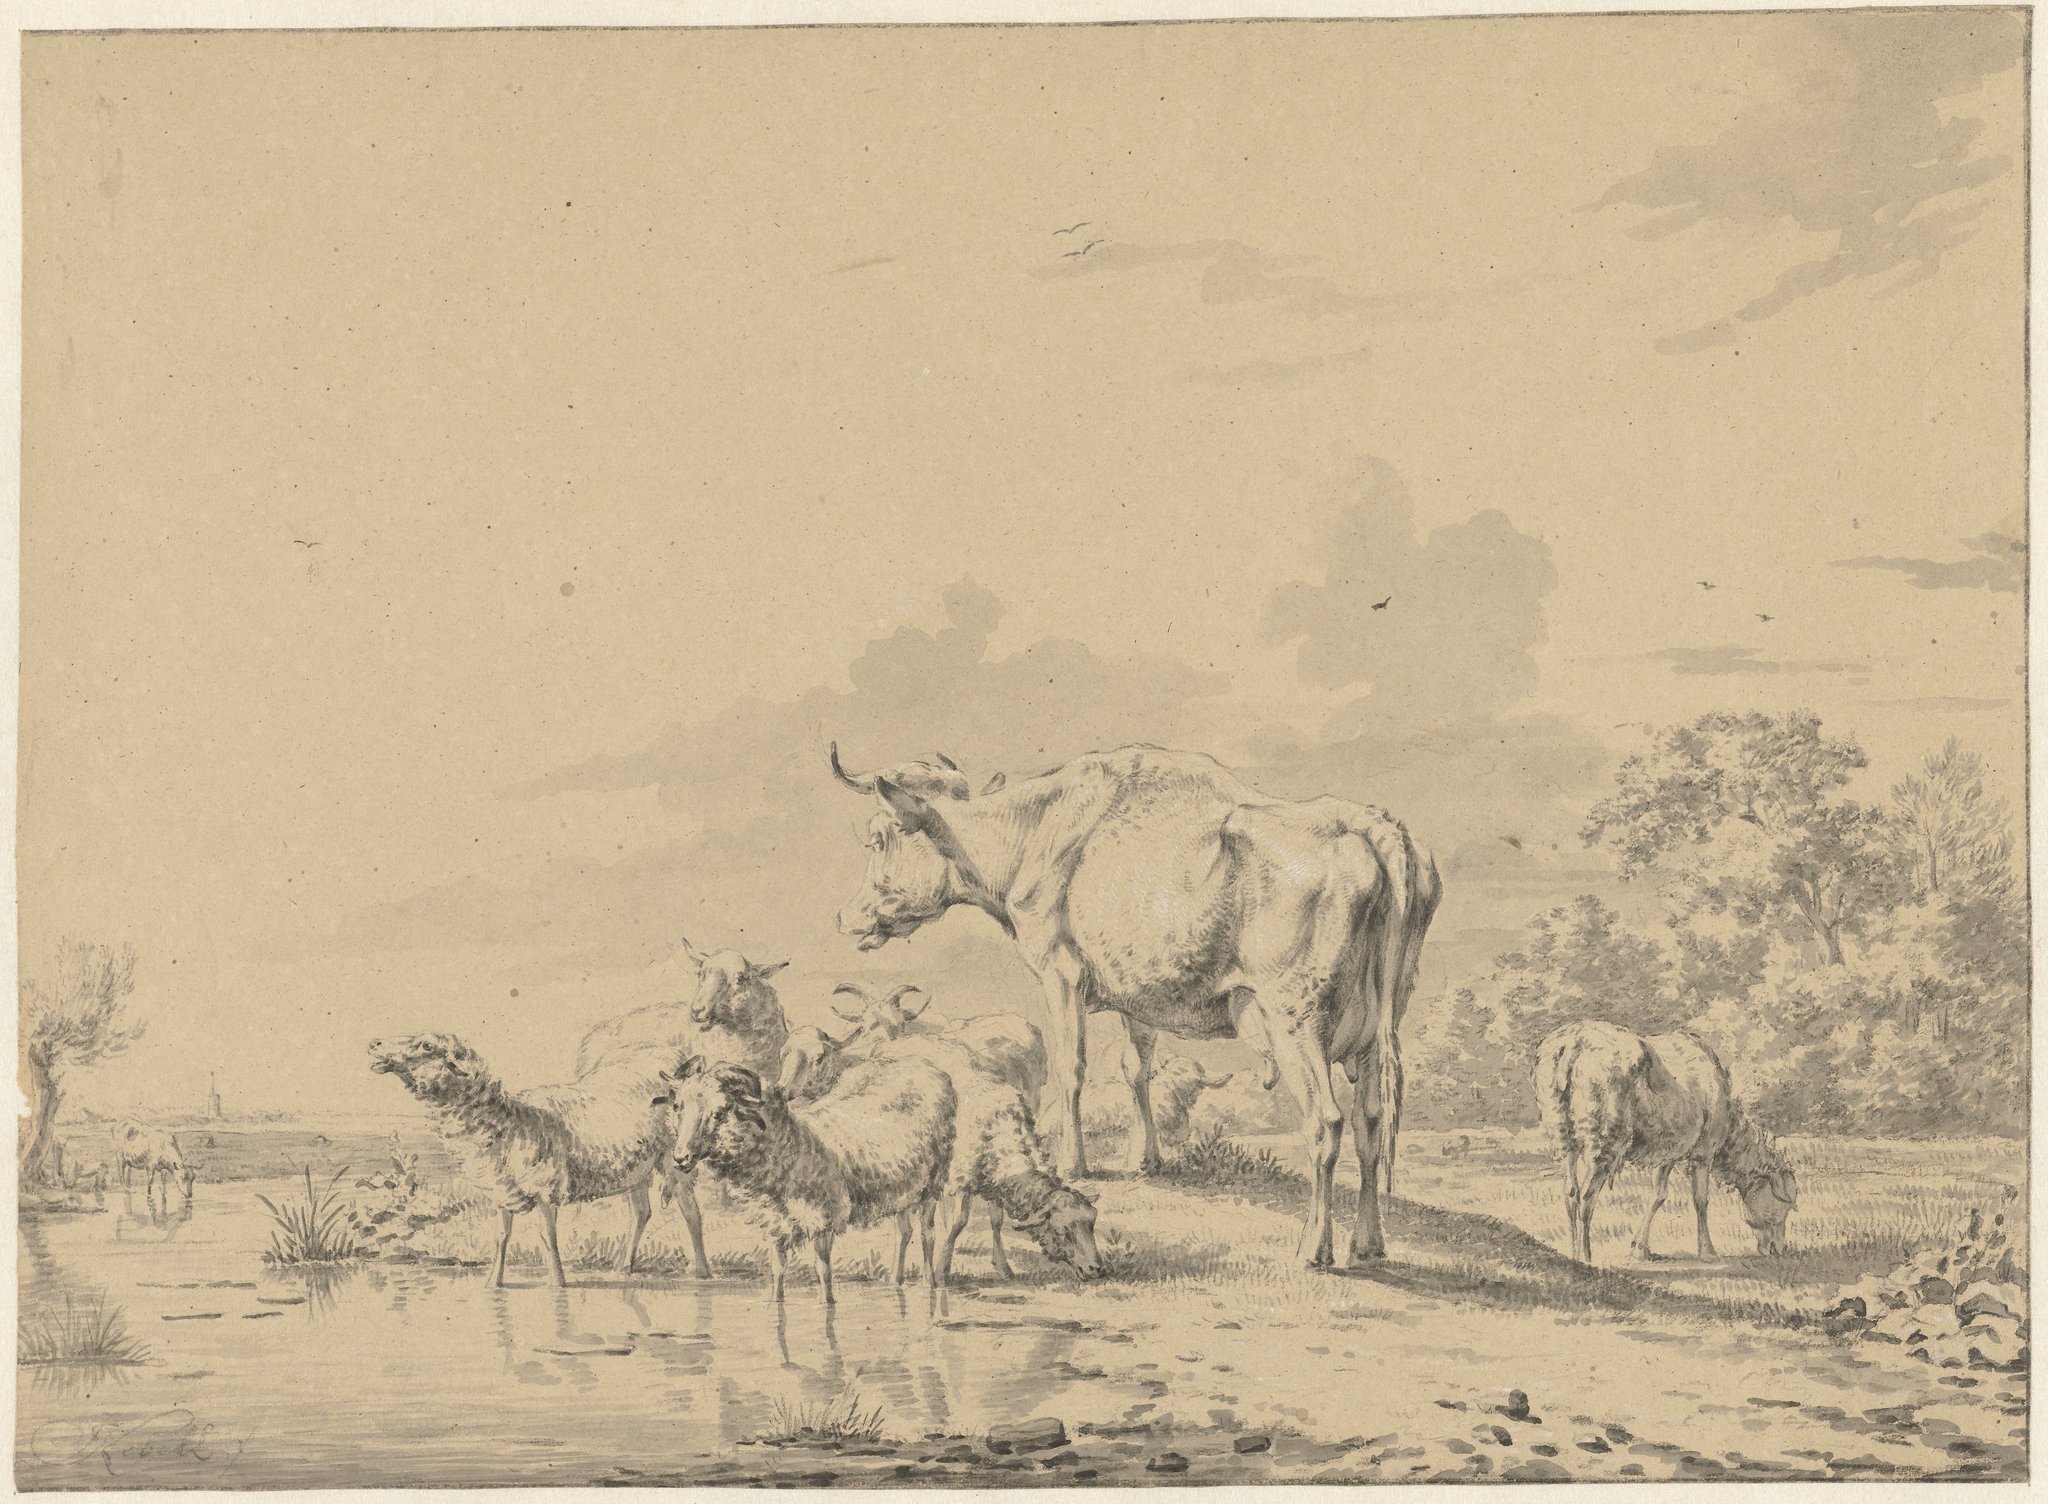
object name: drawing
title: Koe tussen schapen aan waterkant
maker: jan kobell (ii)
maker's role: draughtsman, painter, print maker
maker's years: 1778-1814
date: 1788-1814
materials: chalk, paper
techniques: brush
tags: cow, cattle, sheep